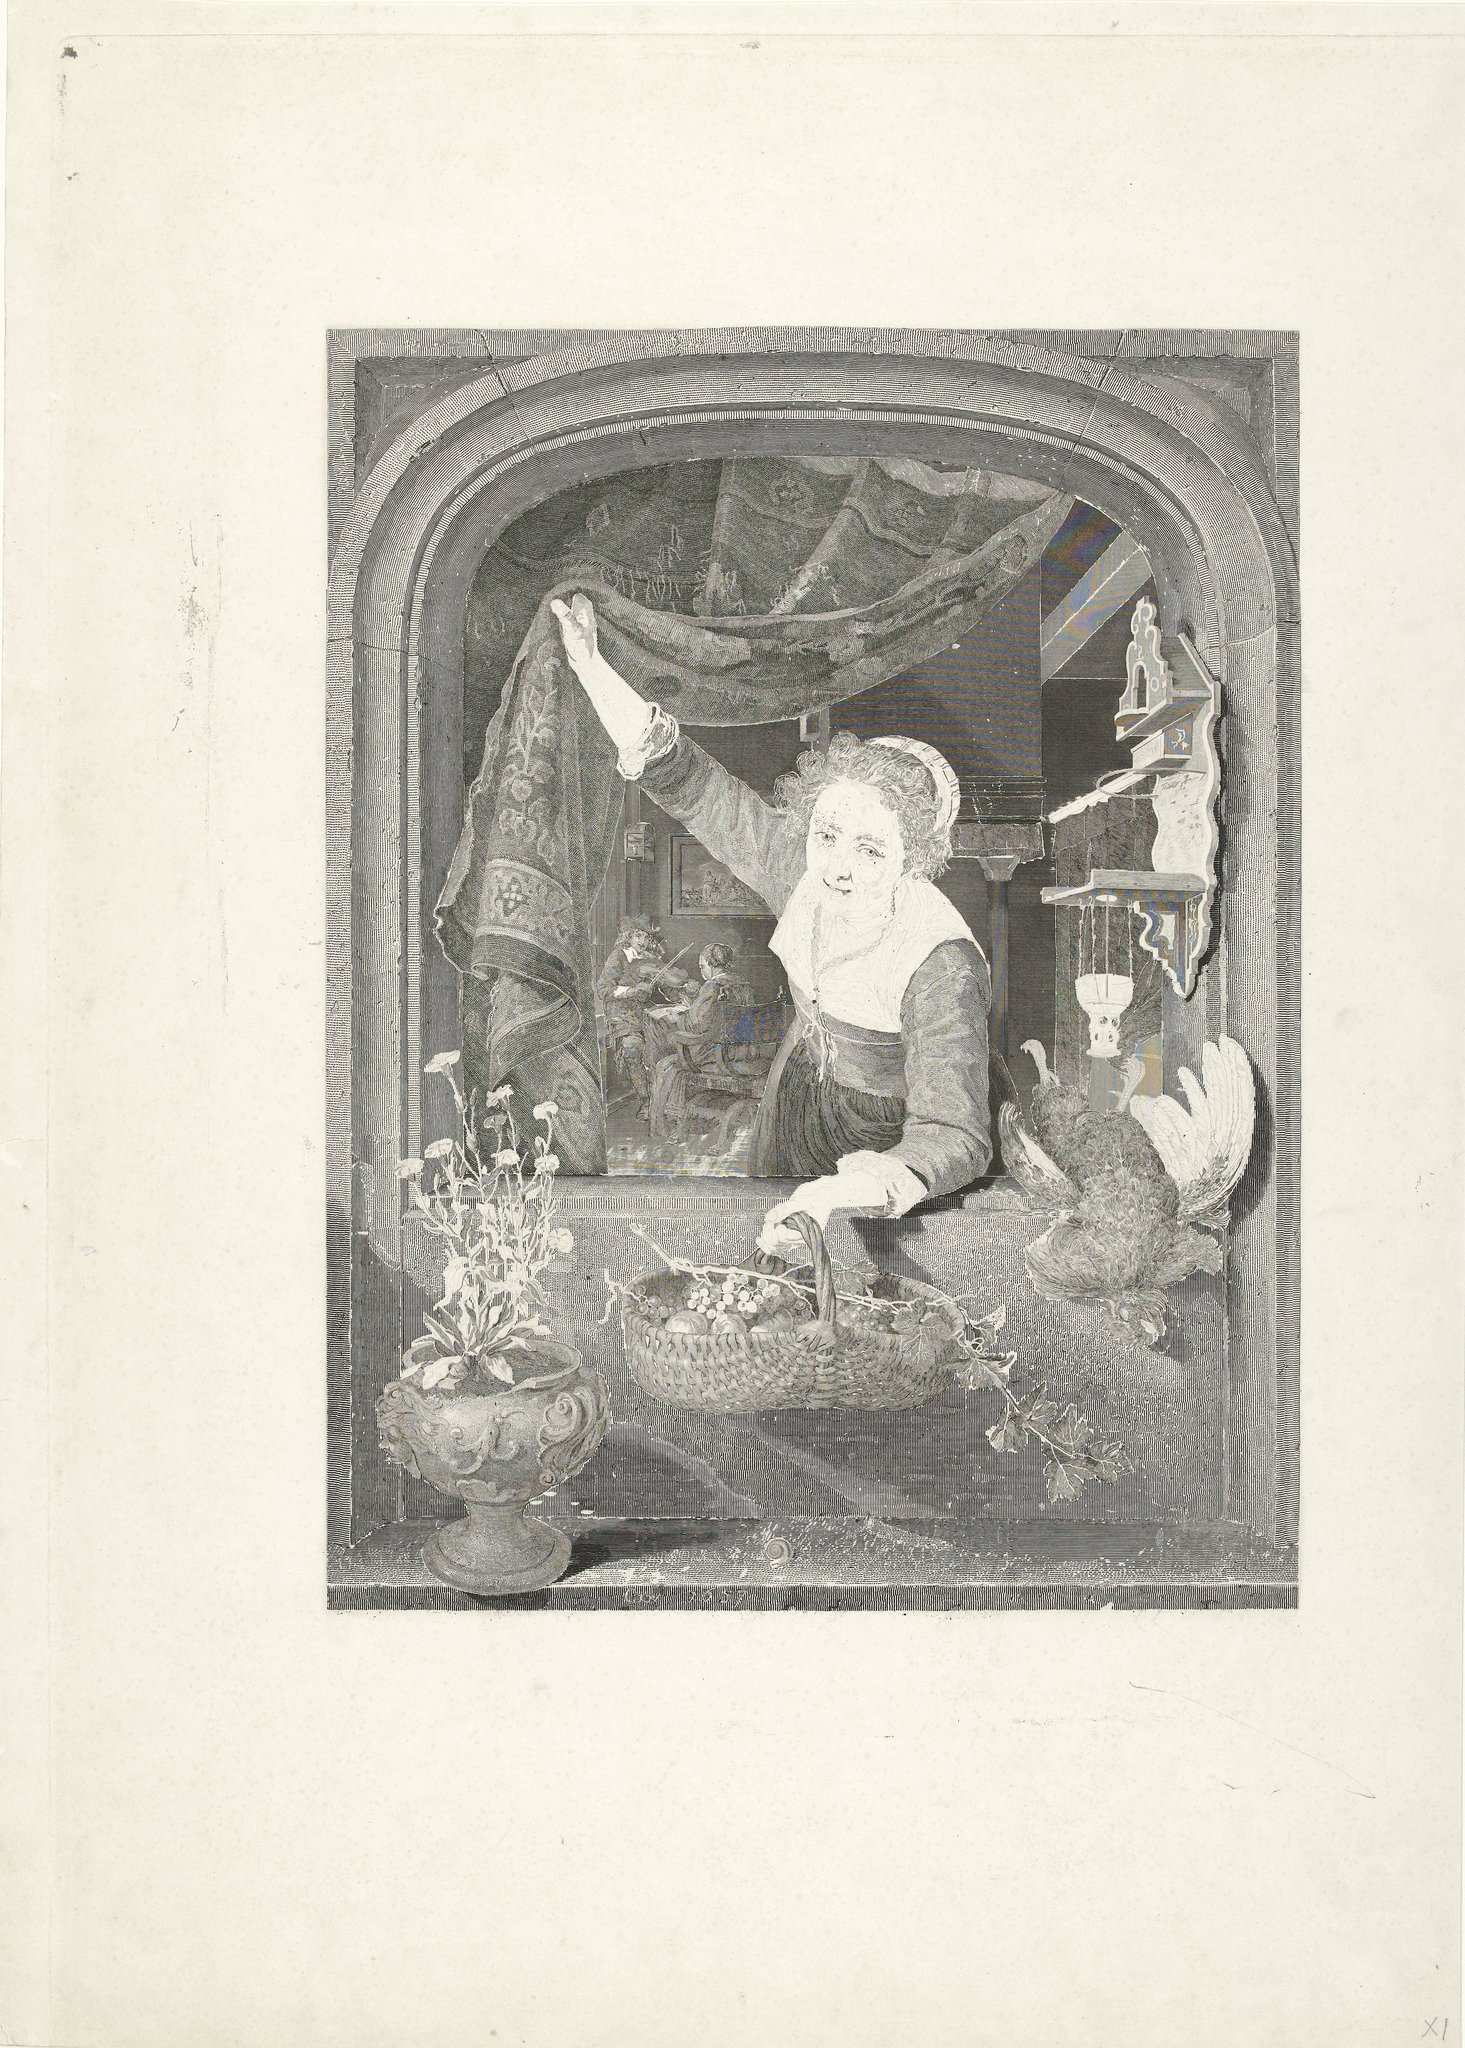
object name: print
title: Vrouw met mand met vruchten in de hand bij het raam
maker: henricus wilhelmus couwenberg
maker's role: draughtsman, print maker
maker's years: 1814-1845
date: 1840-1842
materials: paper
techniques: etching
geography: amsterdam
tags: instrumental and vocal music together, human figure at (open) window, seen from outside, shop-window, show-window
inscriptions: collector's mark: Lugt 2228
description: Een jonge vrouw met een mand met vruchten in de hand hangt uit een venster. Ze houdt het gordijn opzij zodat het interieur achter haar zichtbaar is. In het vertrek zijn een man en een vrouw aan het musiceren. In de vensterbank hangt een vogelhuis, ligt een dode haan en staat een vaas met bloemen.